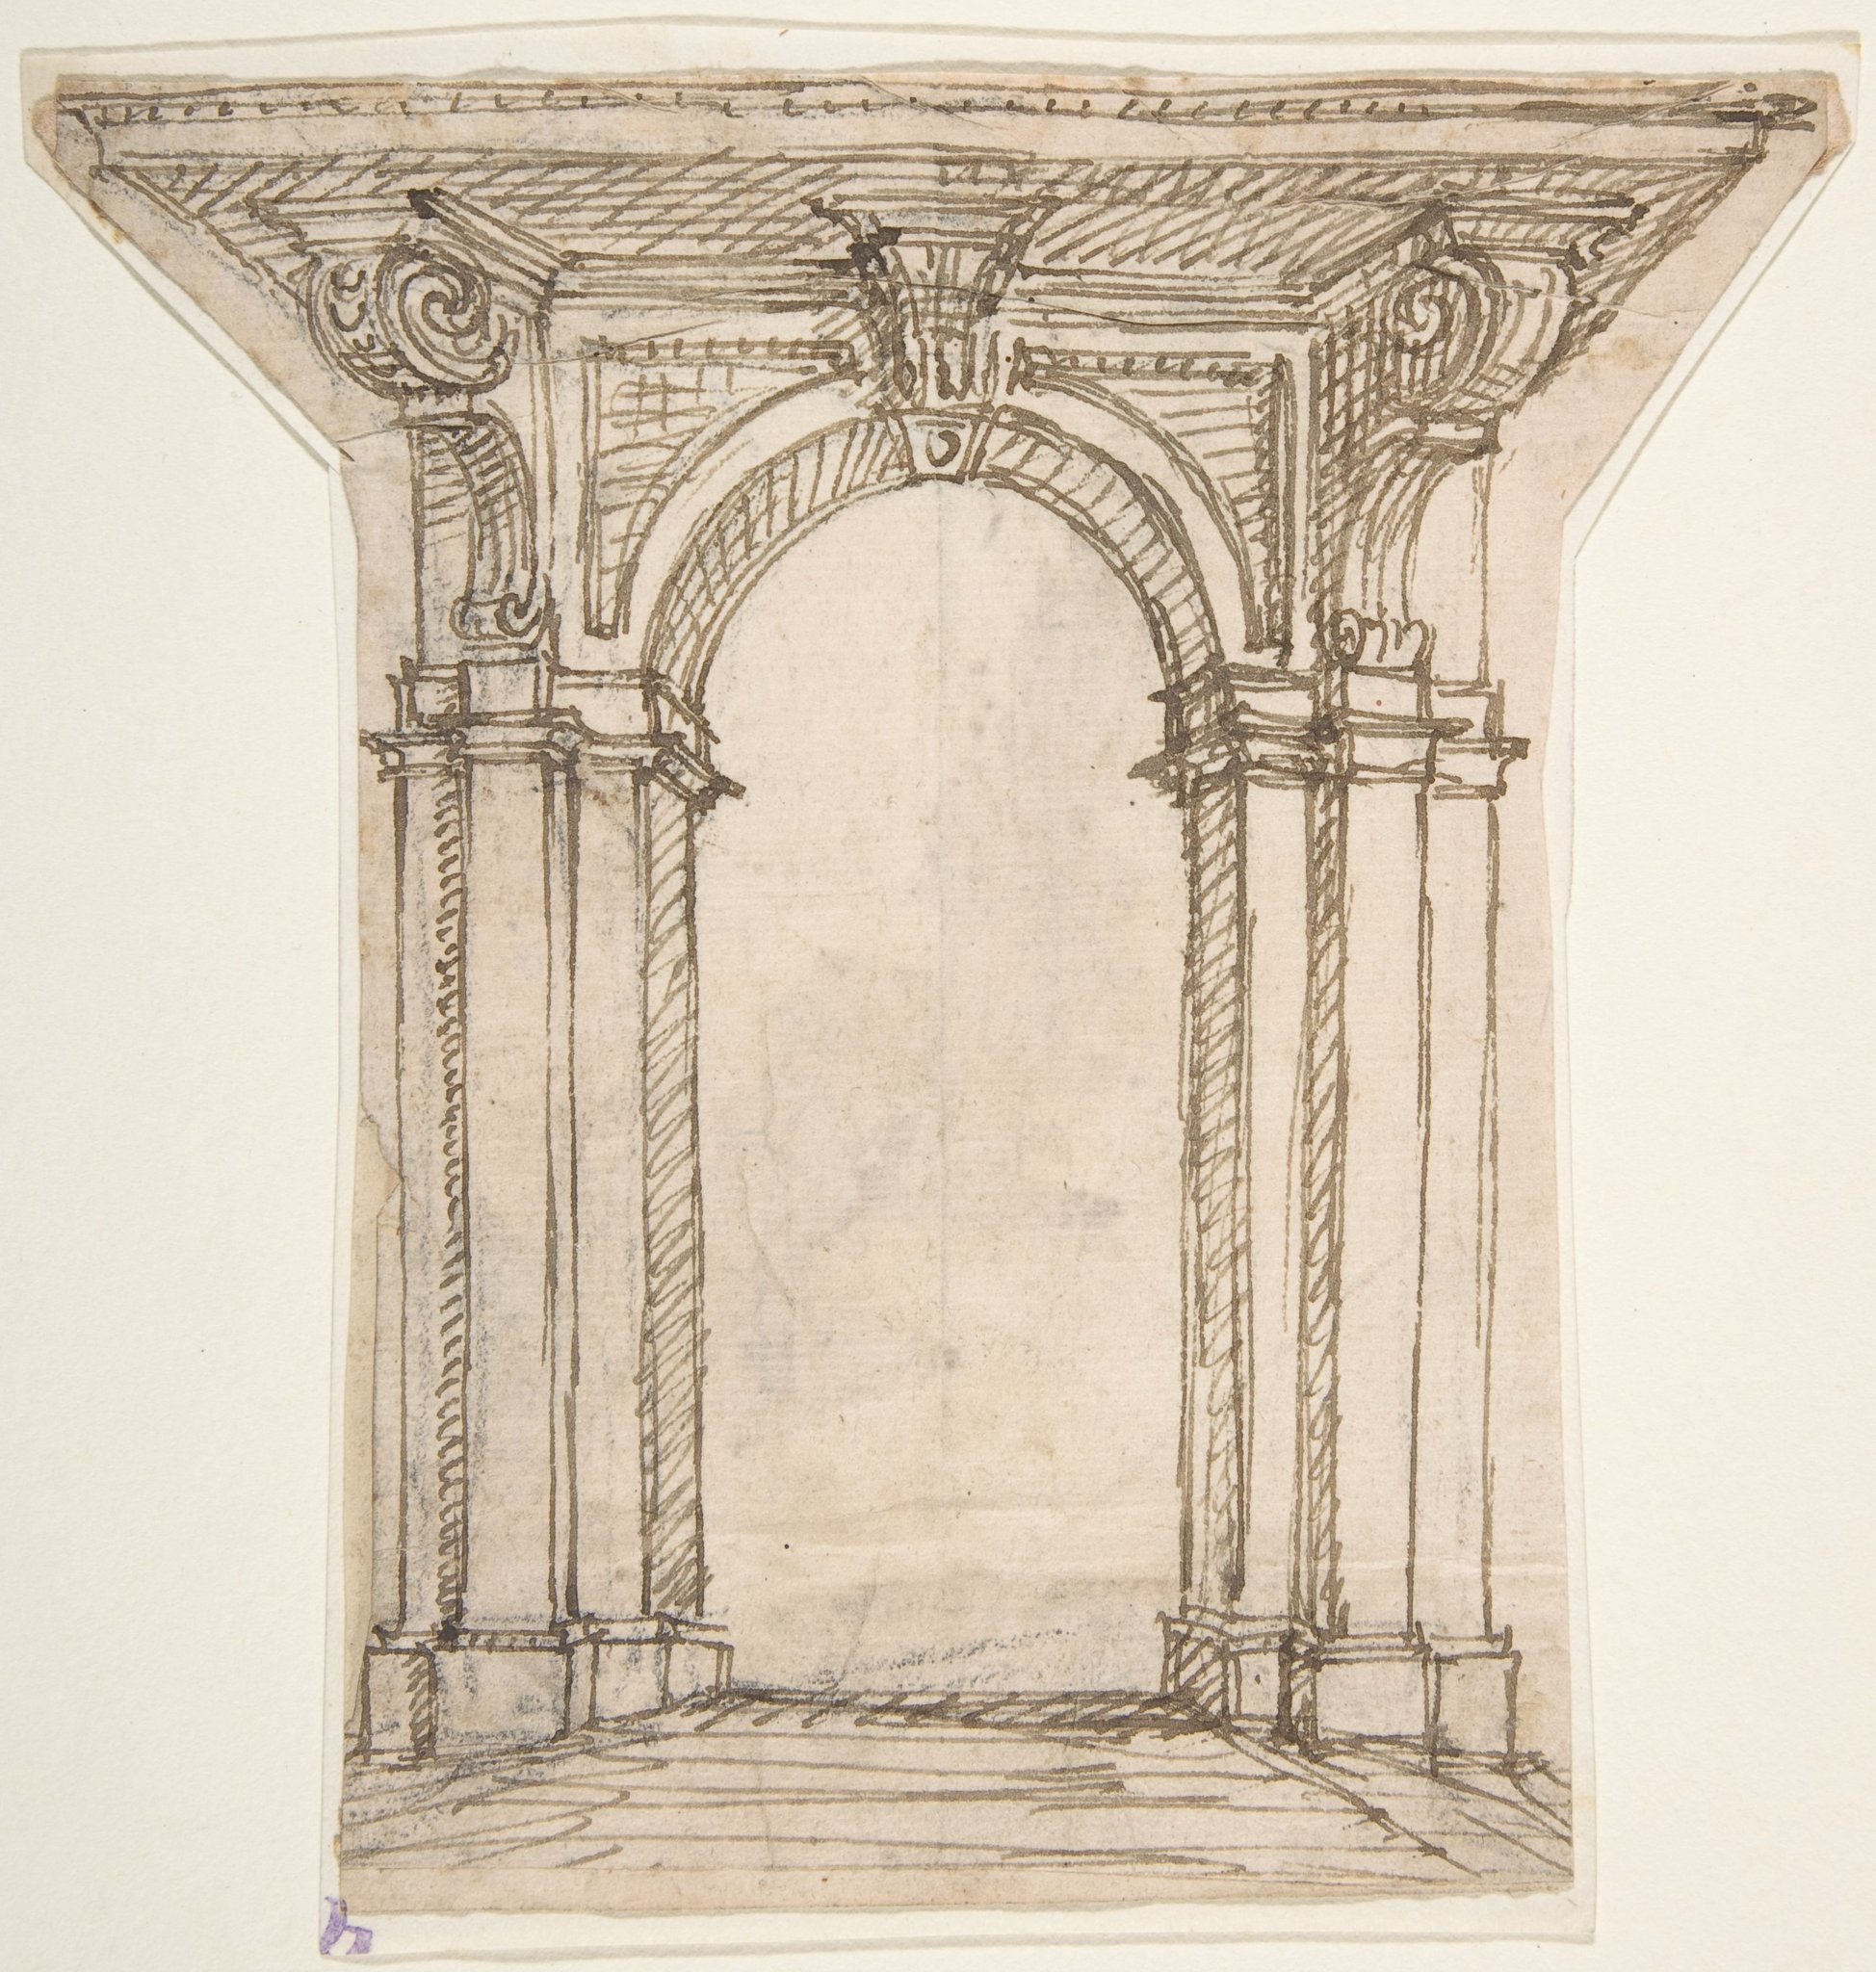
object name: drawing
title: Design for an Entrance Portal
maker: giovanni battista foggini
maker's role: artist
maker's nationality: italian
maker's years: 1652-1725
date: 1672-1725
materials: chalk, ink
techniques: pen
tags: architecture